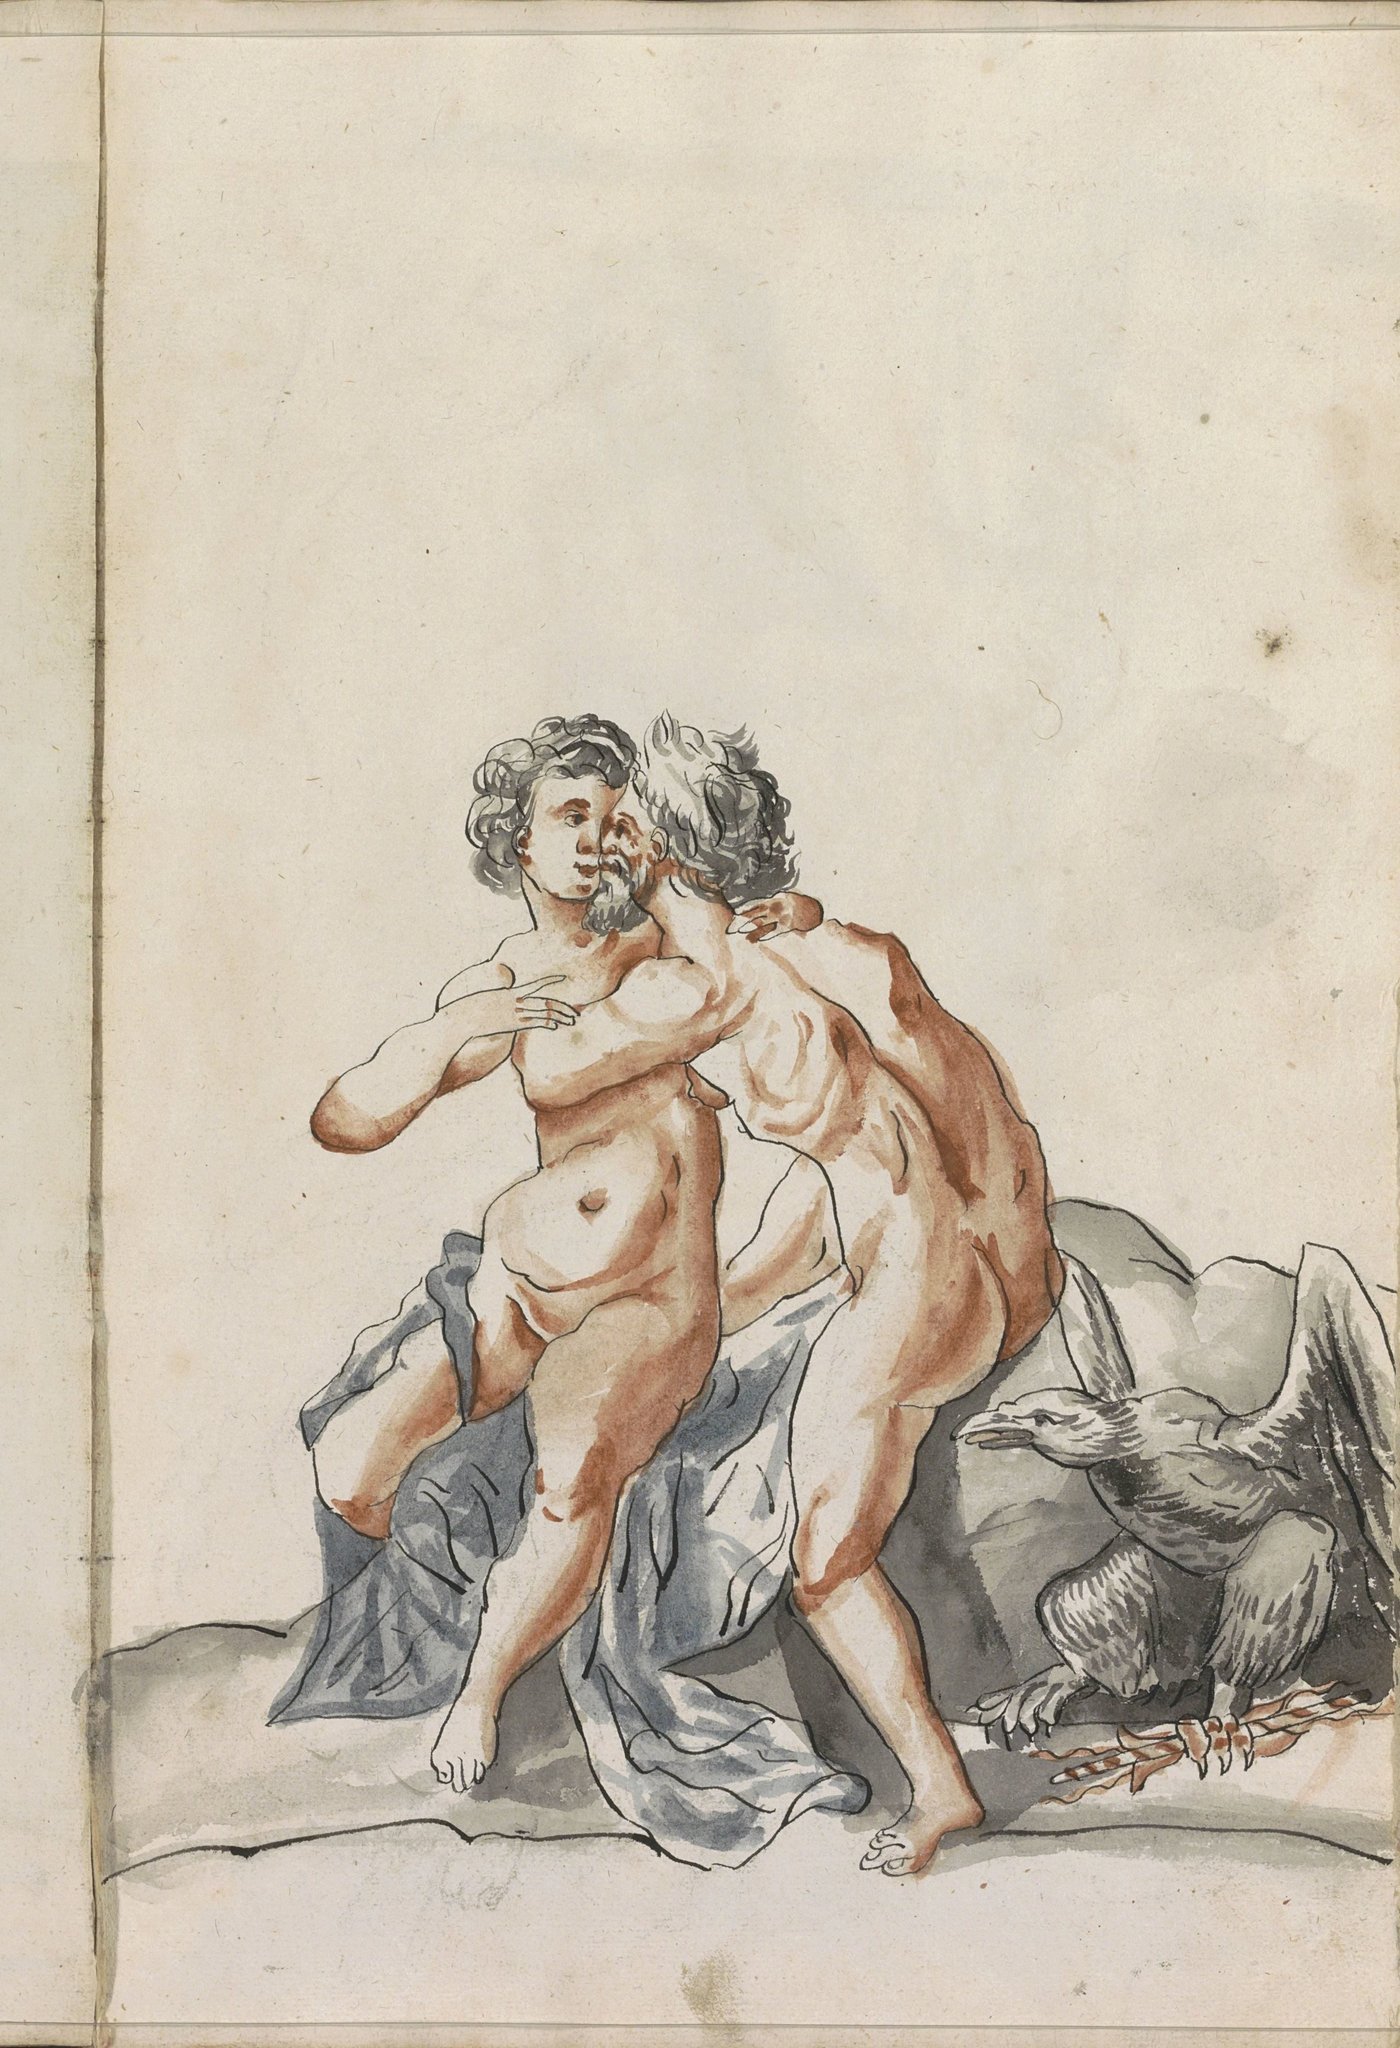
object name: sketchbook leaf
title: Hercules en Deïanira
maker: hendrick van beaumont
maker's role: draughtsman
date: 1696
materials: ink, paper, watercolor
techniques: brush, pen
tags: attributes of jupiter: eagle, hercules in love with deianira, daughter of oeneus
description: Naast het paar staat een adelaar, symbool van Jupiter in plaats van Hercules. Dit is een aanpassing die de tekenaar heeft gedaan ten opzichte van de prent.